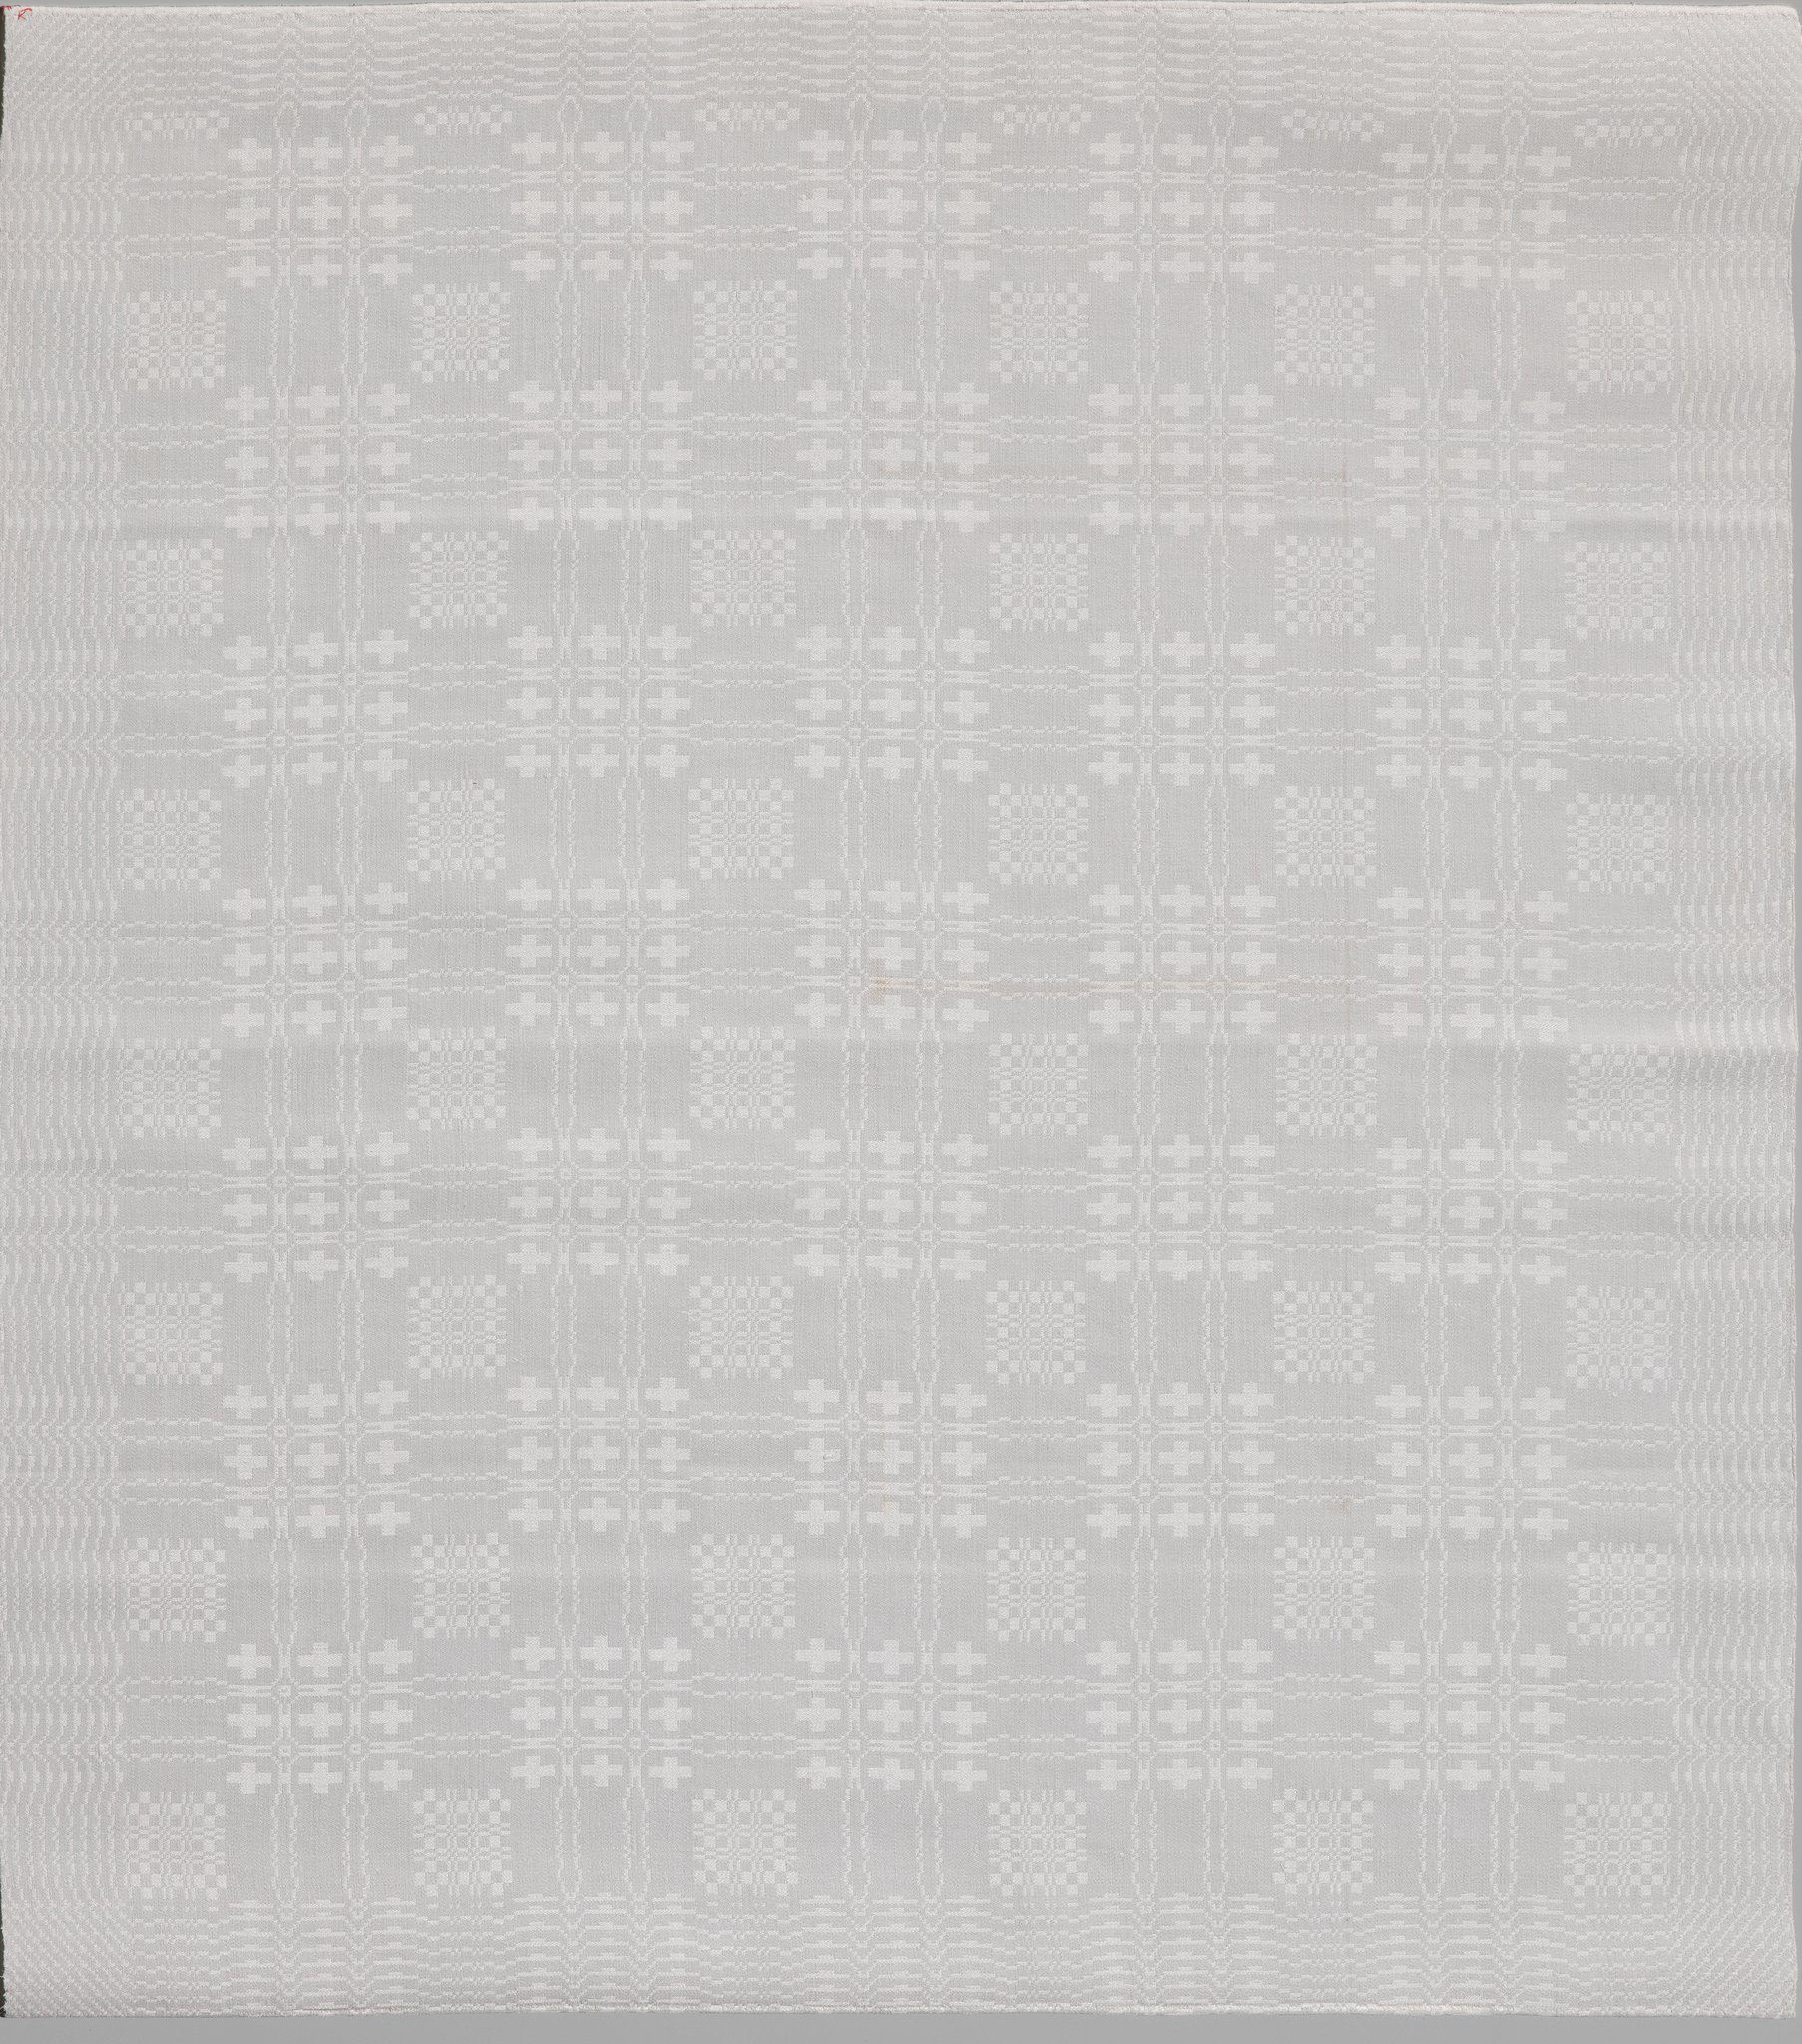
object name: napkin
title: Servet van linnen met pellenpatroon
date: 1825-1850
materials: linen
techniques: peeled fabric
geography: netherlands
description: wit linnen servet met een pellen patroon en randen, merk K WH 2oonl